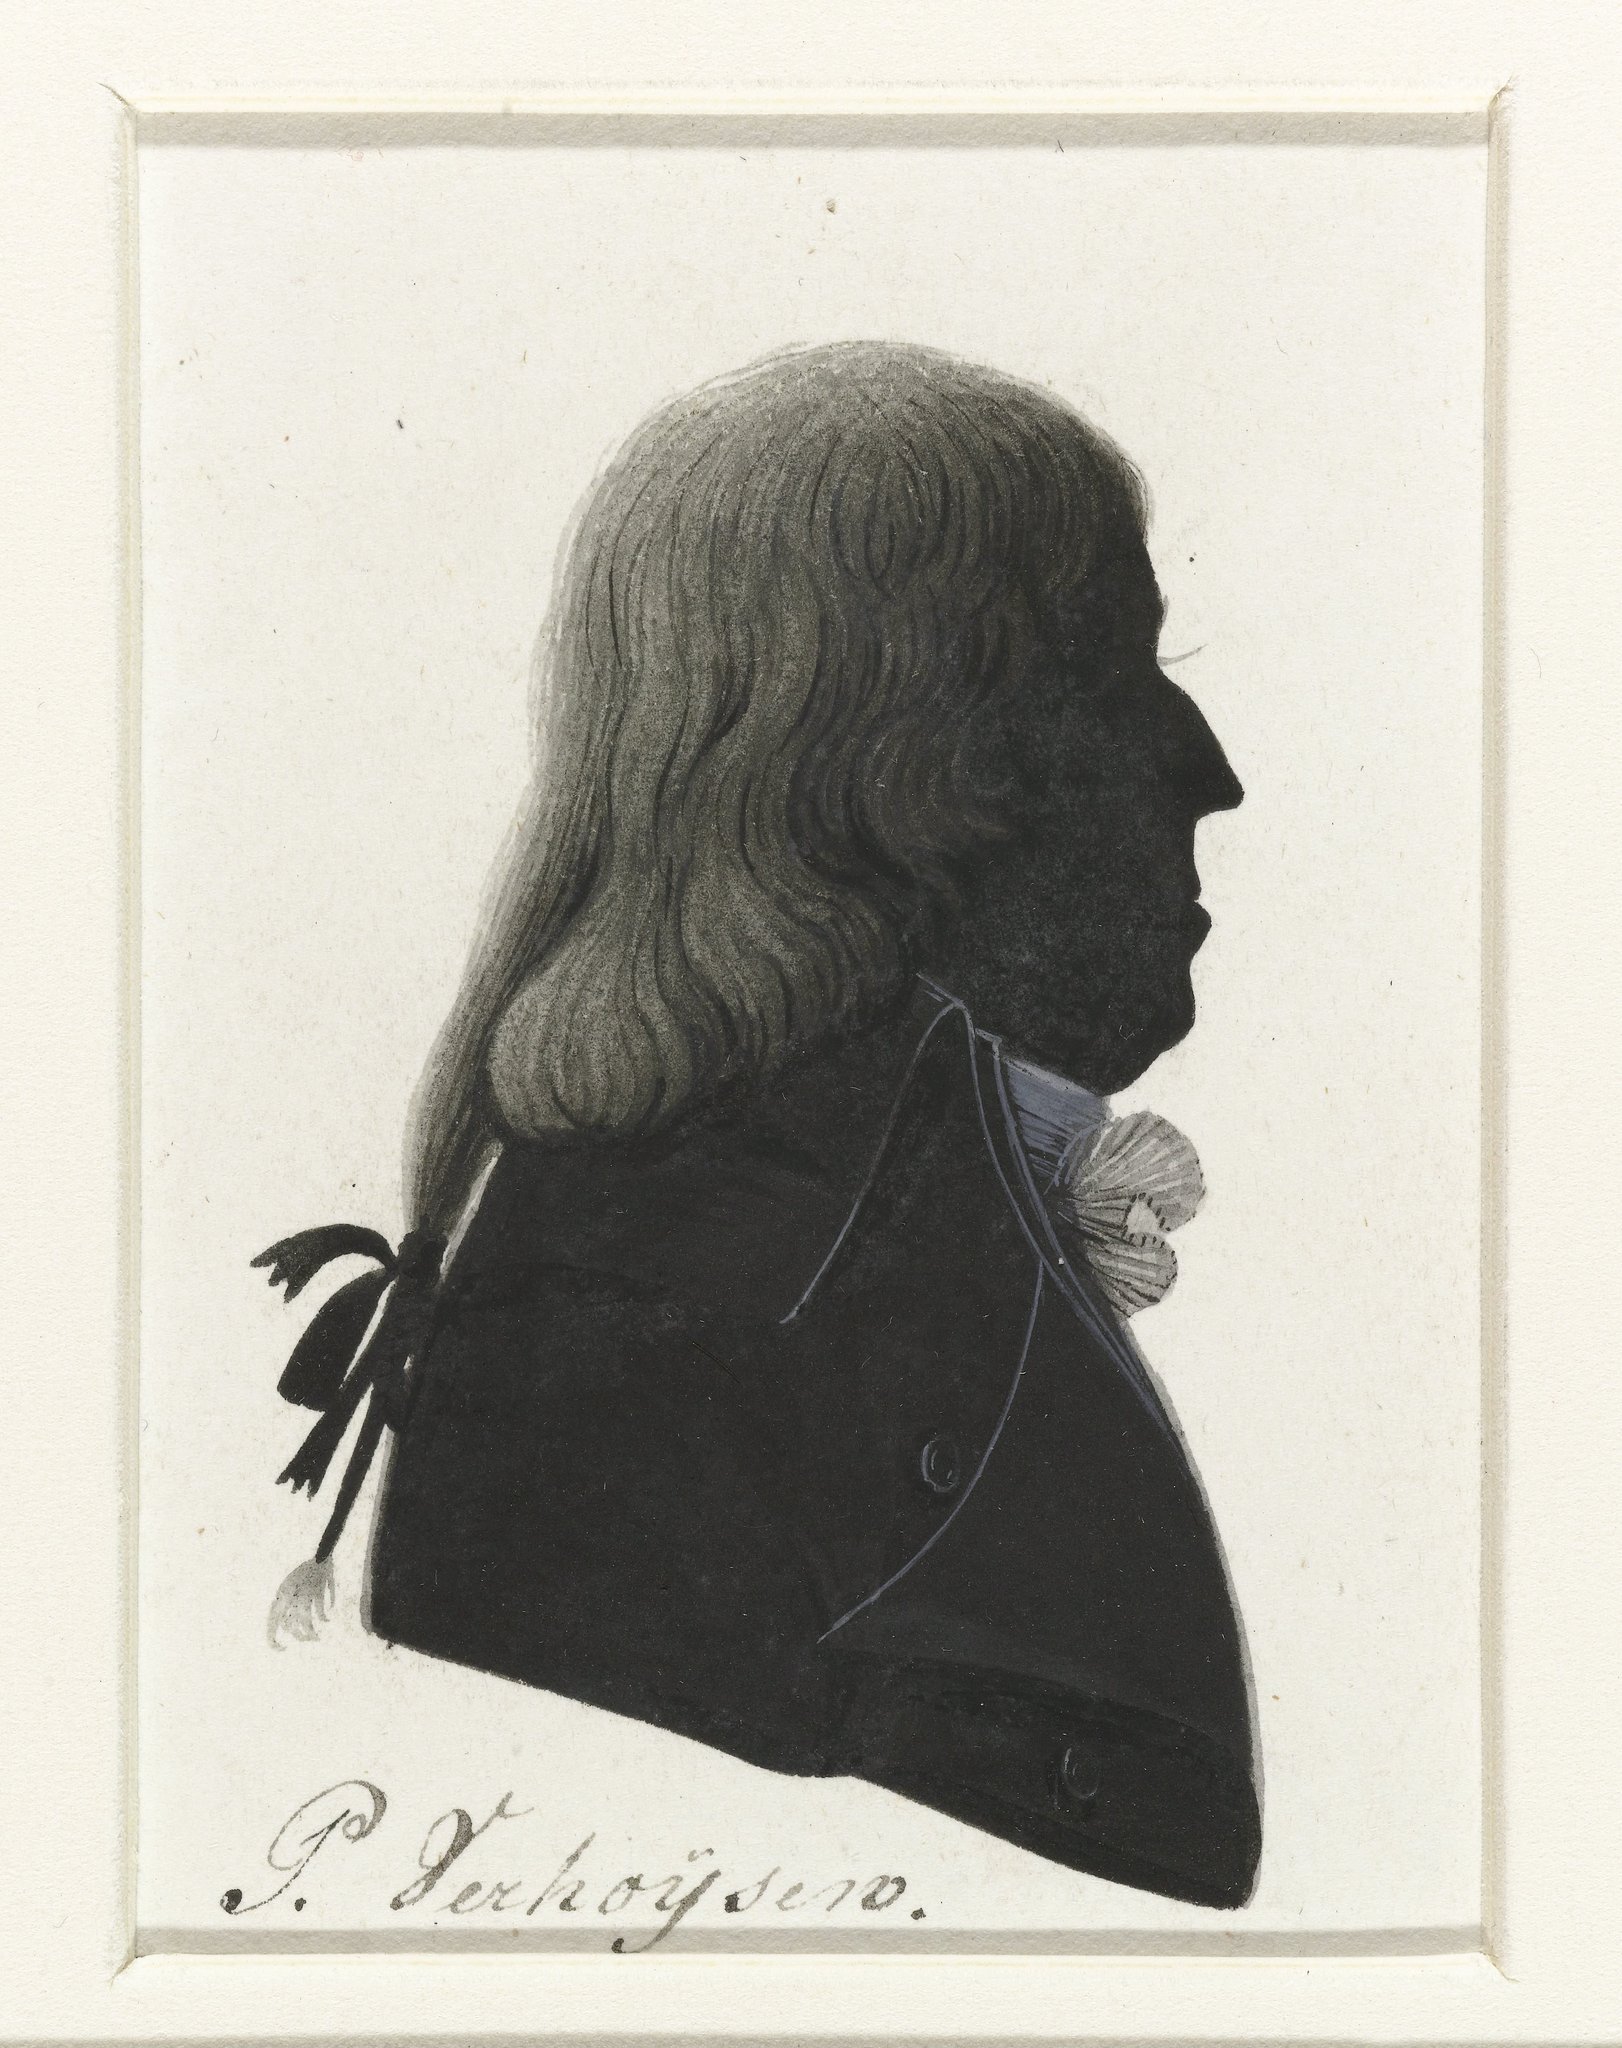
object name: silhouette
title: Representanten van de eerste Nationale Vergadering van de Bataafse Republiek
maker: hausdorff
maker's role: draughtsman, print maker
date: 1796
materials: ink, paper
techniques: drawing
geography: netherlands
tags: historical persons (+ profile portrait), the hague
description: Silhouettes of members of the National Assembly. India ink on paper, 1796. Early in 1795 Stadholder William V fled to England. In the Republic a new regime was installed. A year later, the country held its first general election. Every Dutch man over the age of twenty and not on poor relief was entitled to vote for a candidate to the National Assembly, the parliament of the Batavian Republic, as the country was known between 1795 and 1806. The 126 representatives who sat in the assembly were drawn from the educated, progressive elite of Dutch society.